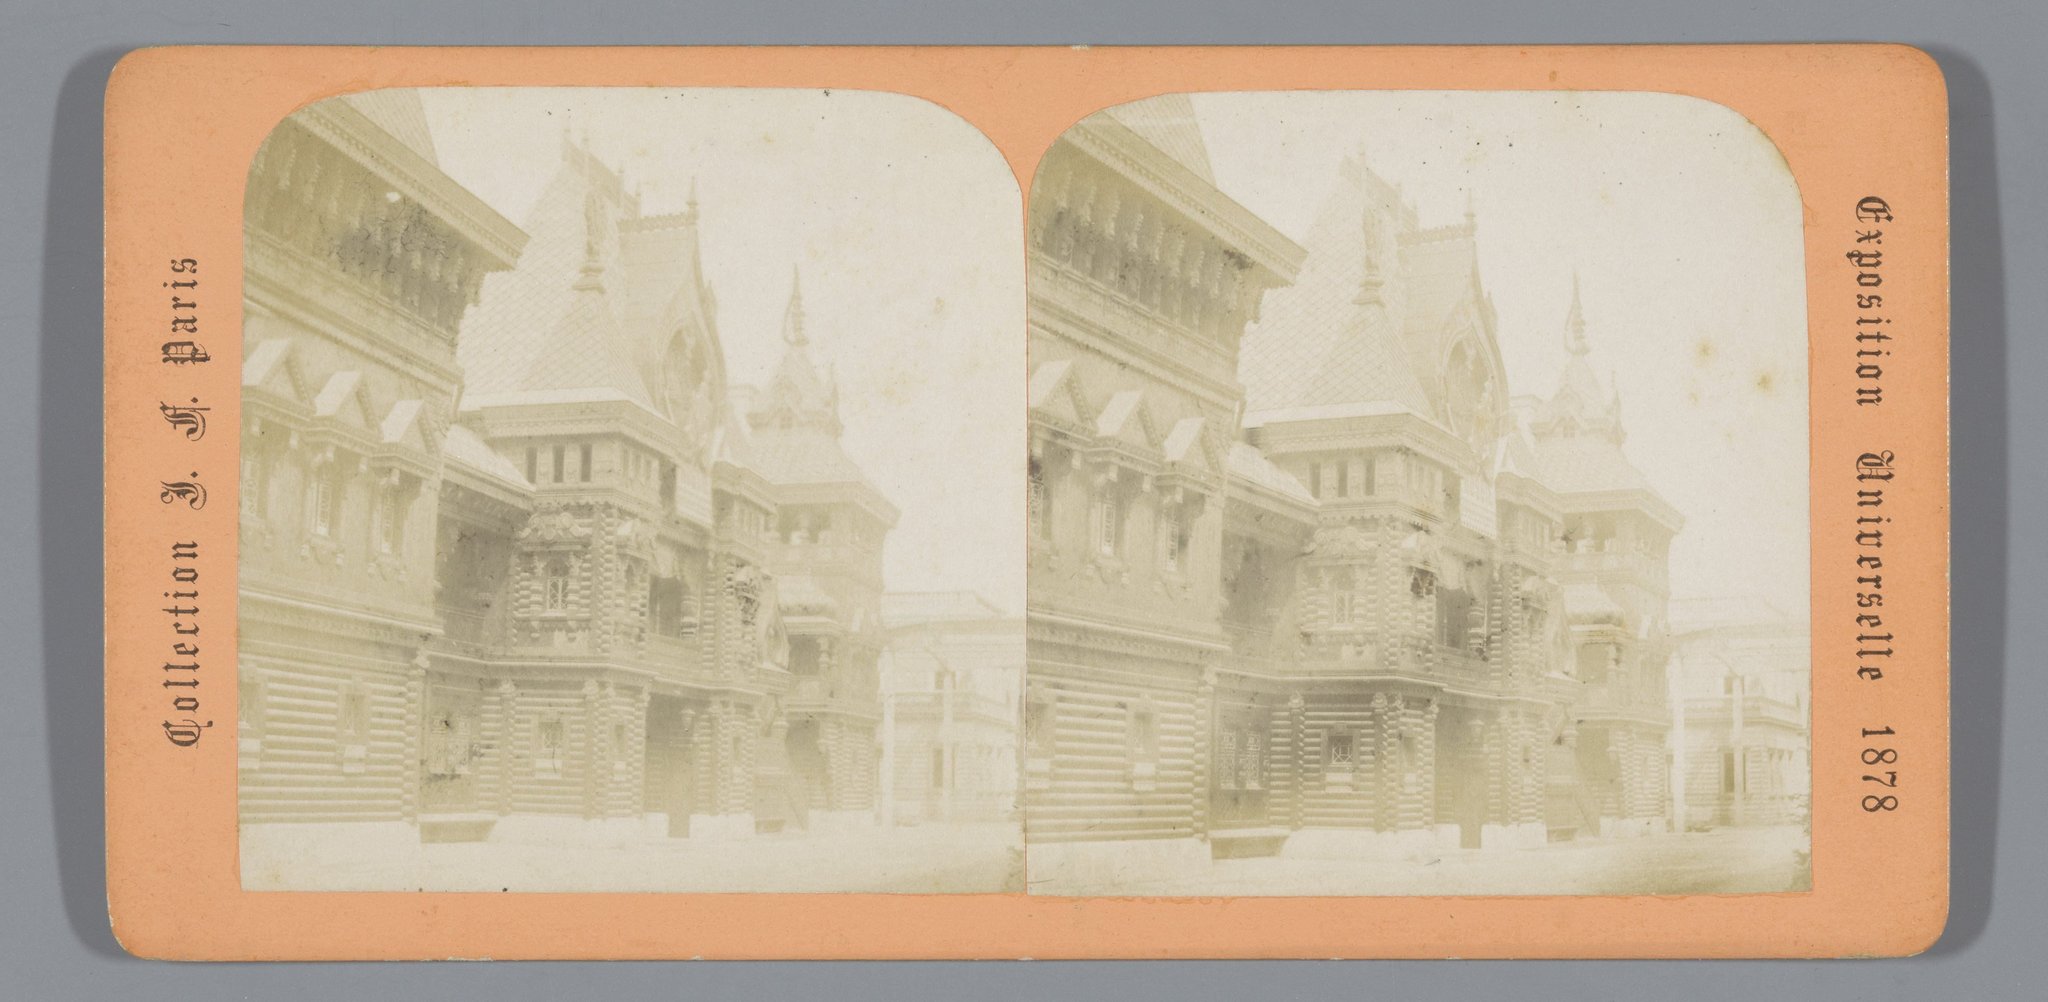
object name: stereograph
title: Russische paviljoen op de Wereldtentoonstelling van 1878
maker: jf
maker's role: fotograaf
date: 1878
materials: cardboard, paper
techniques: albumen print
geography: paris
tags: world fair, world exhibition, paris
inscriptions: inscription: ‘Russie’